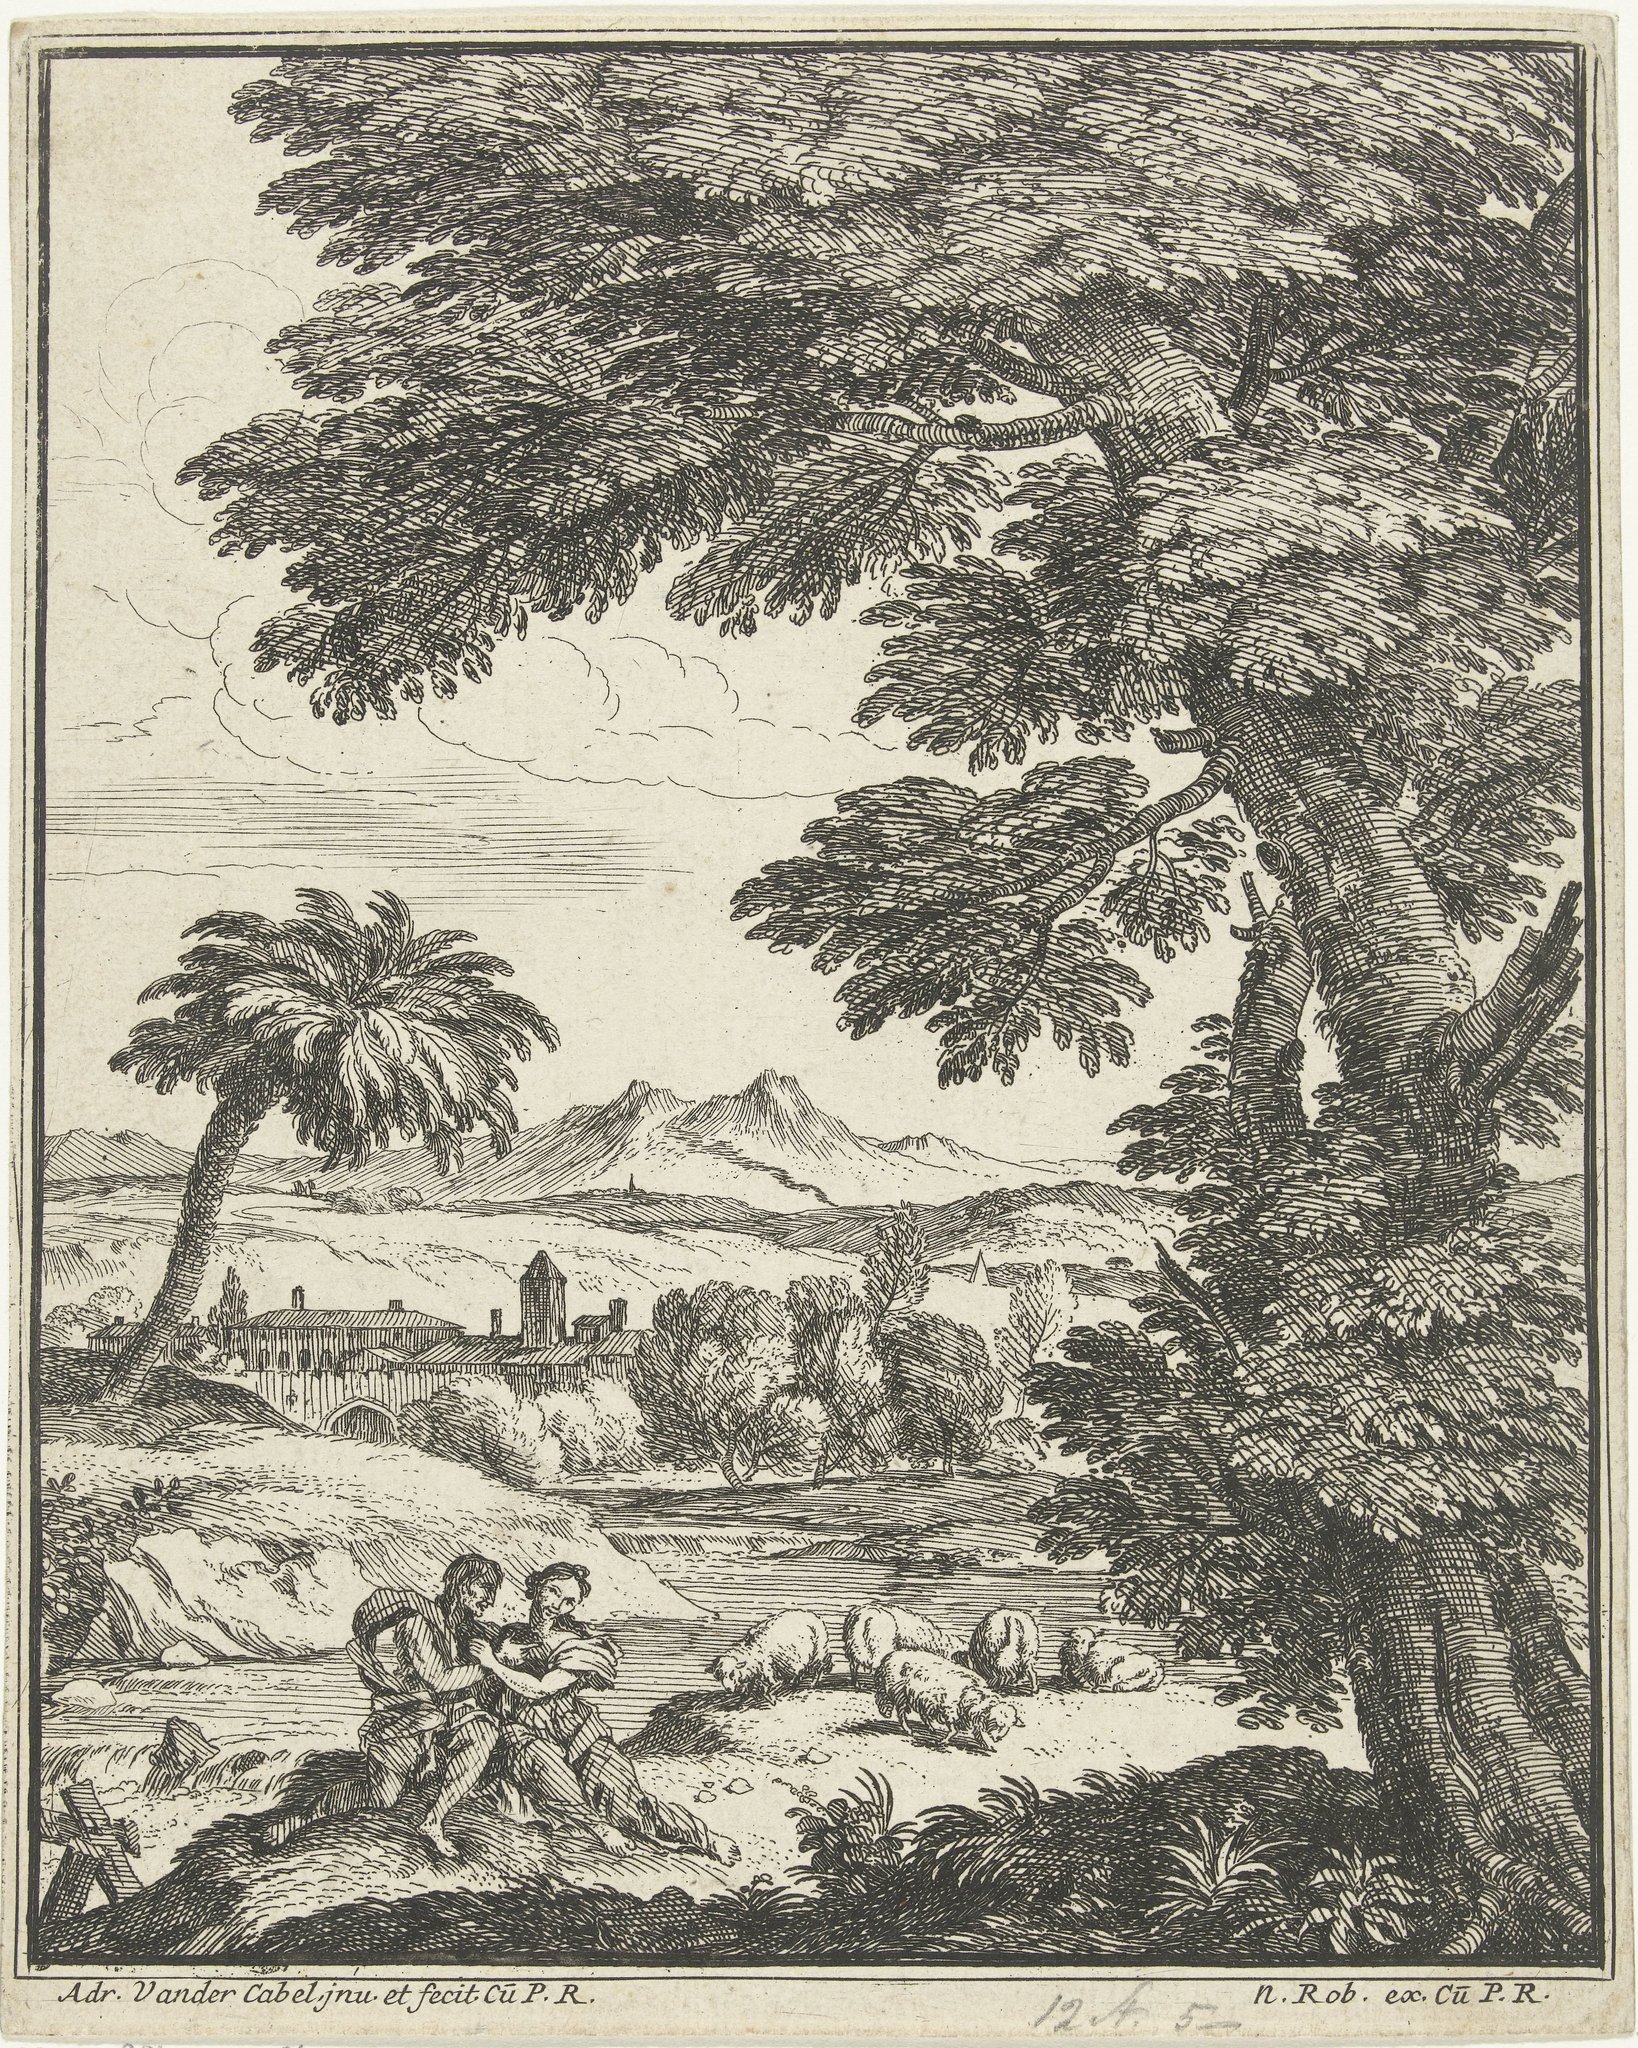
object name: print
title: Landschappen met schaapsherders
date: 1648-1705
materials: paper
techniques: etching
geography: france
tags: herding, herdsman, herdswoman, shepherd, shepherdess, cowherd, etc., the (nude) human figure; 'corpo humano' (ripa) (+ caressing, courting, making love)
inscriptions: collector's mark: Lugt 2228